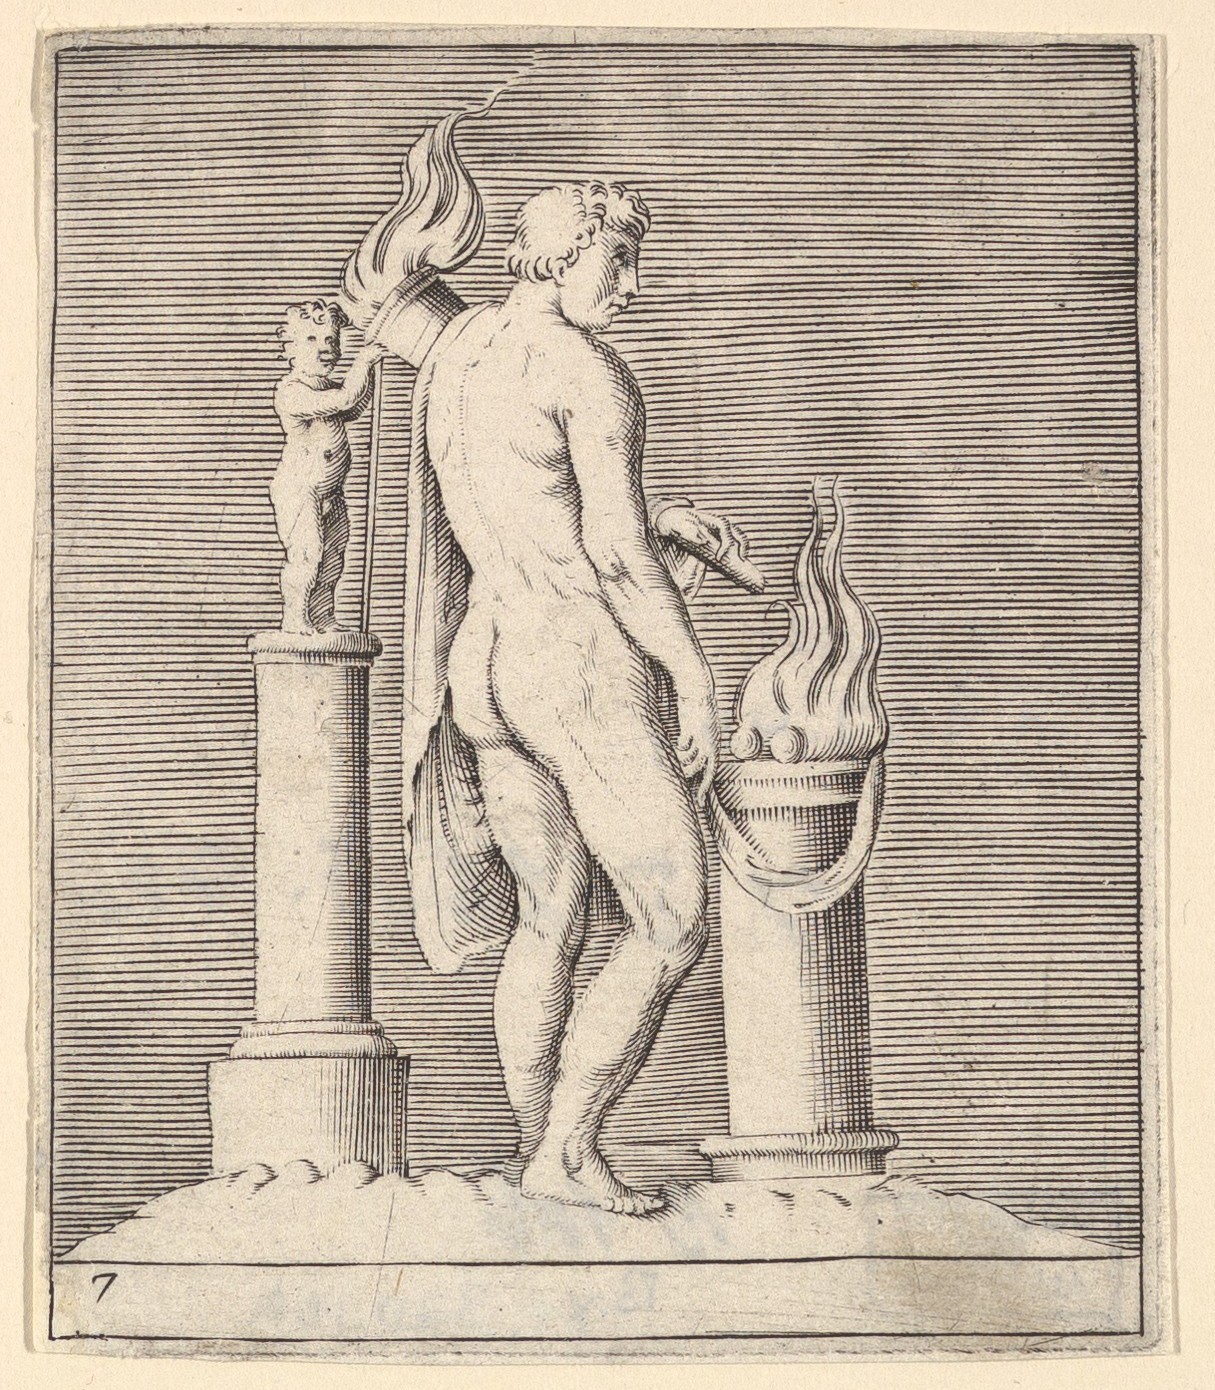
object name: print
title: Man with Torch between Flaming Altar and Statuette, from "Ex Antiquis Cameorum et Gemmae Delineata/ Liber Secundus/et ab Enea Vico Parmen Incis"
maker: anonymous, italian, 16th century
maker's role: artist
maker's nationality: italian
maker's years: 1500-1600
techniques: engraving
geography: rome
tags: altars,male nudes,fire